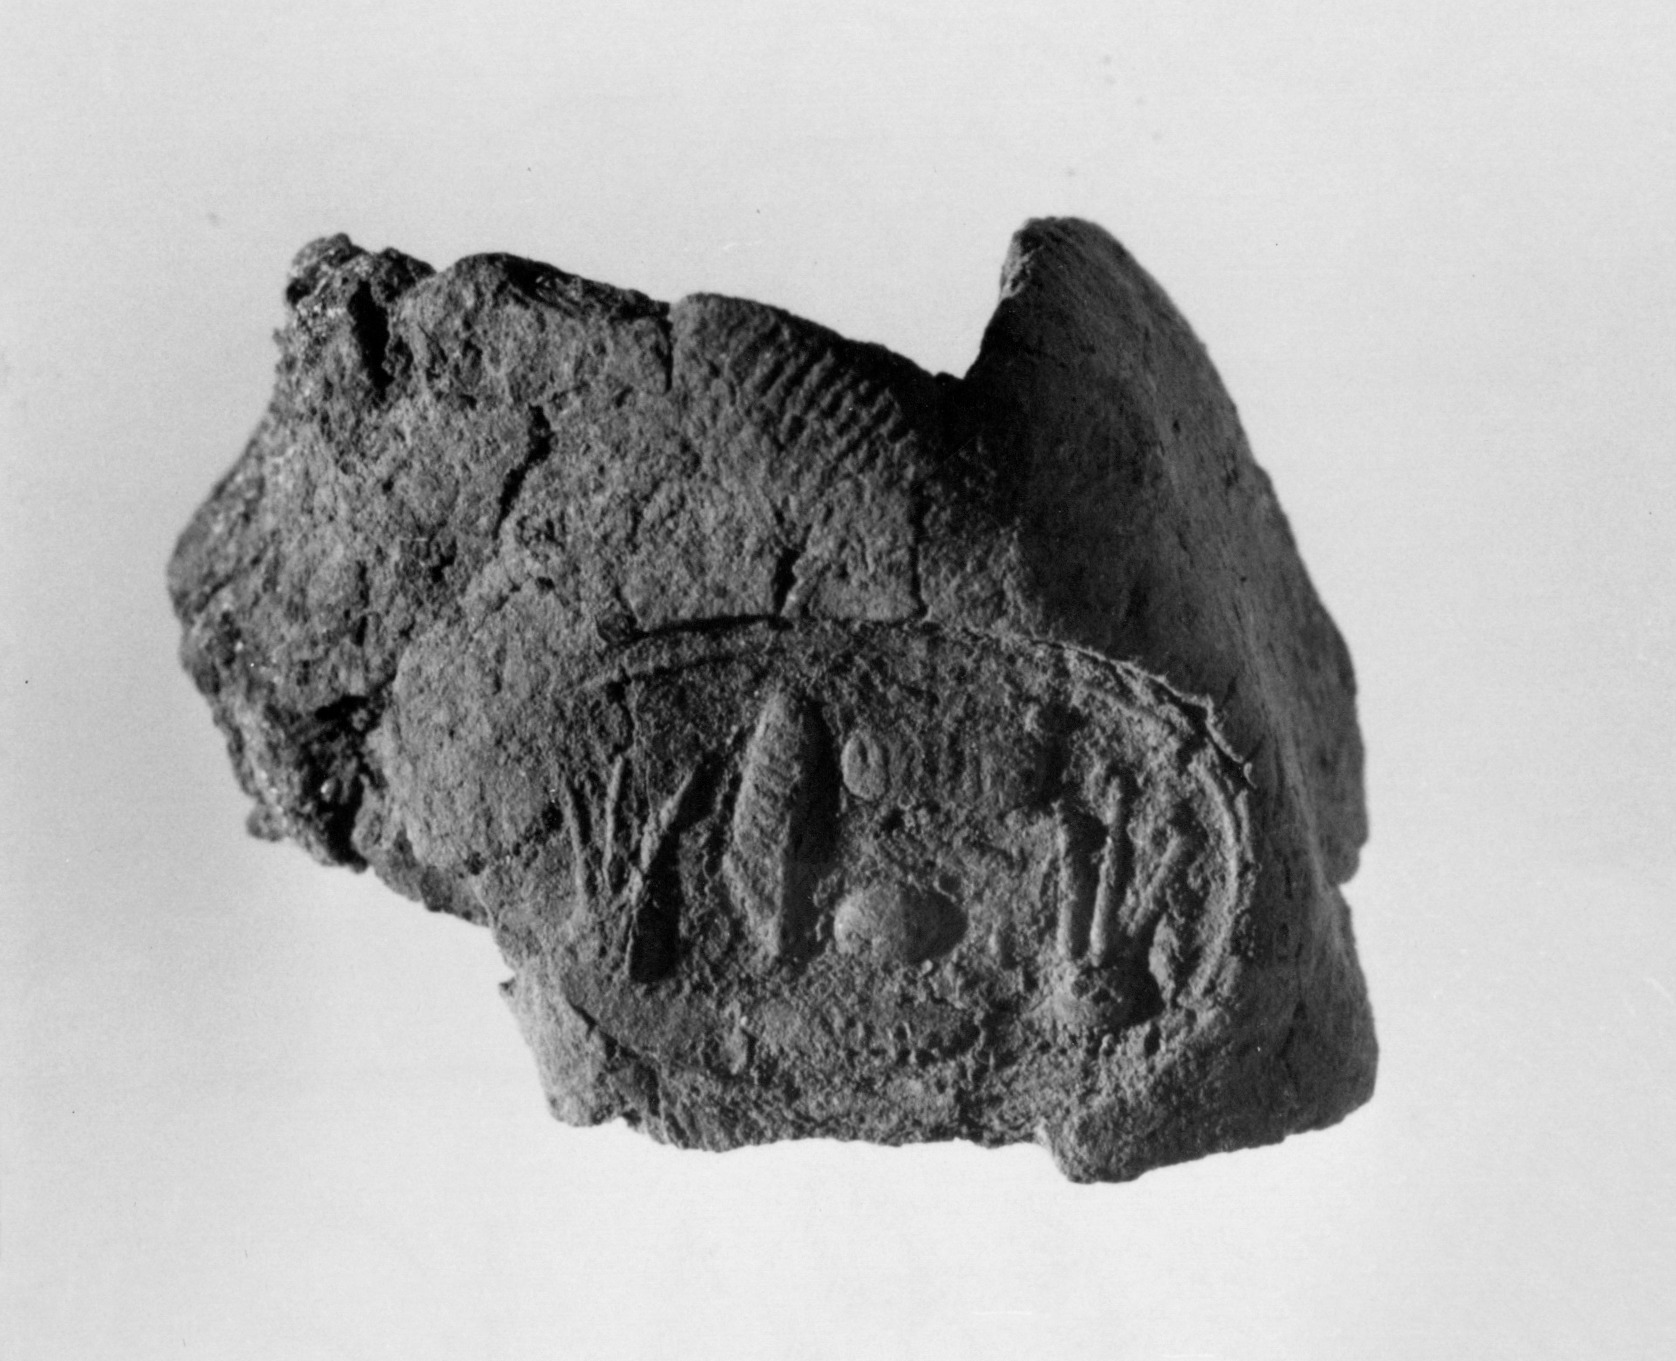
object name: sealing, amun re, upper egypt, lower egypt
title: Document Sealing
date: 1390-1352 BCE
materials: mud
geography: egypt